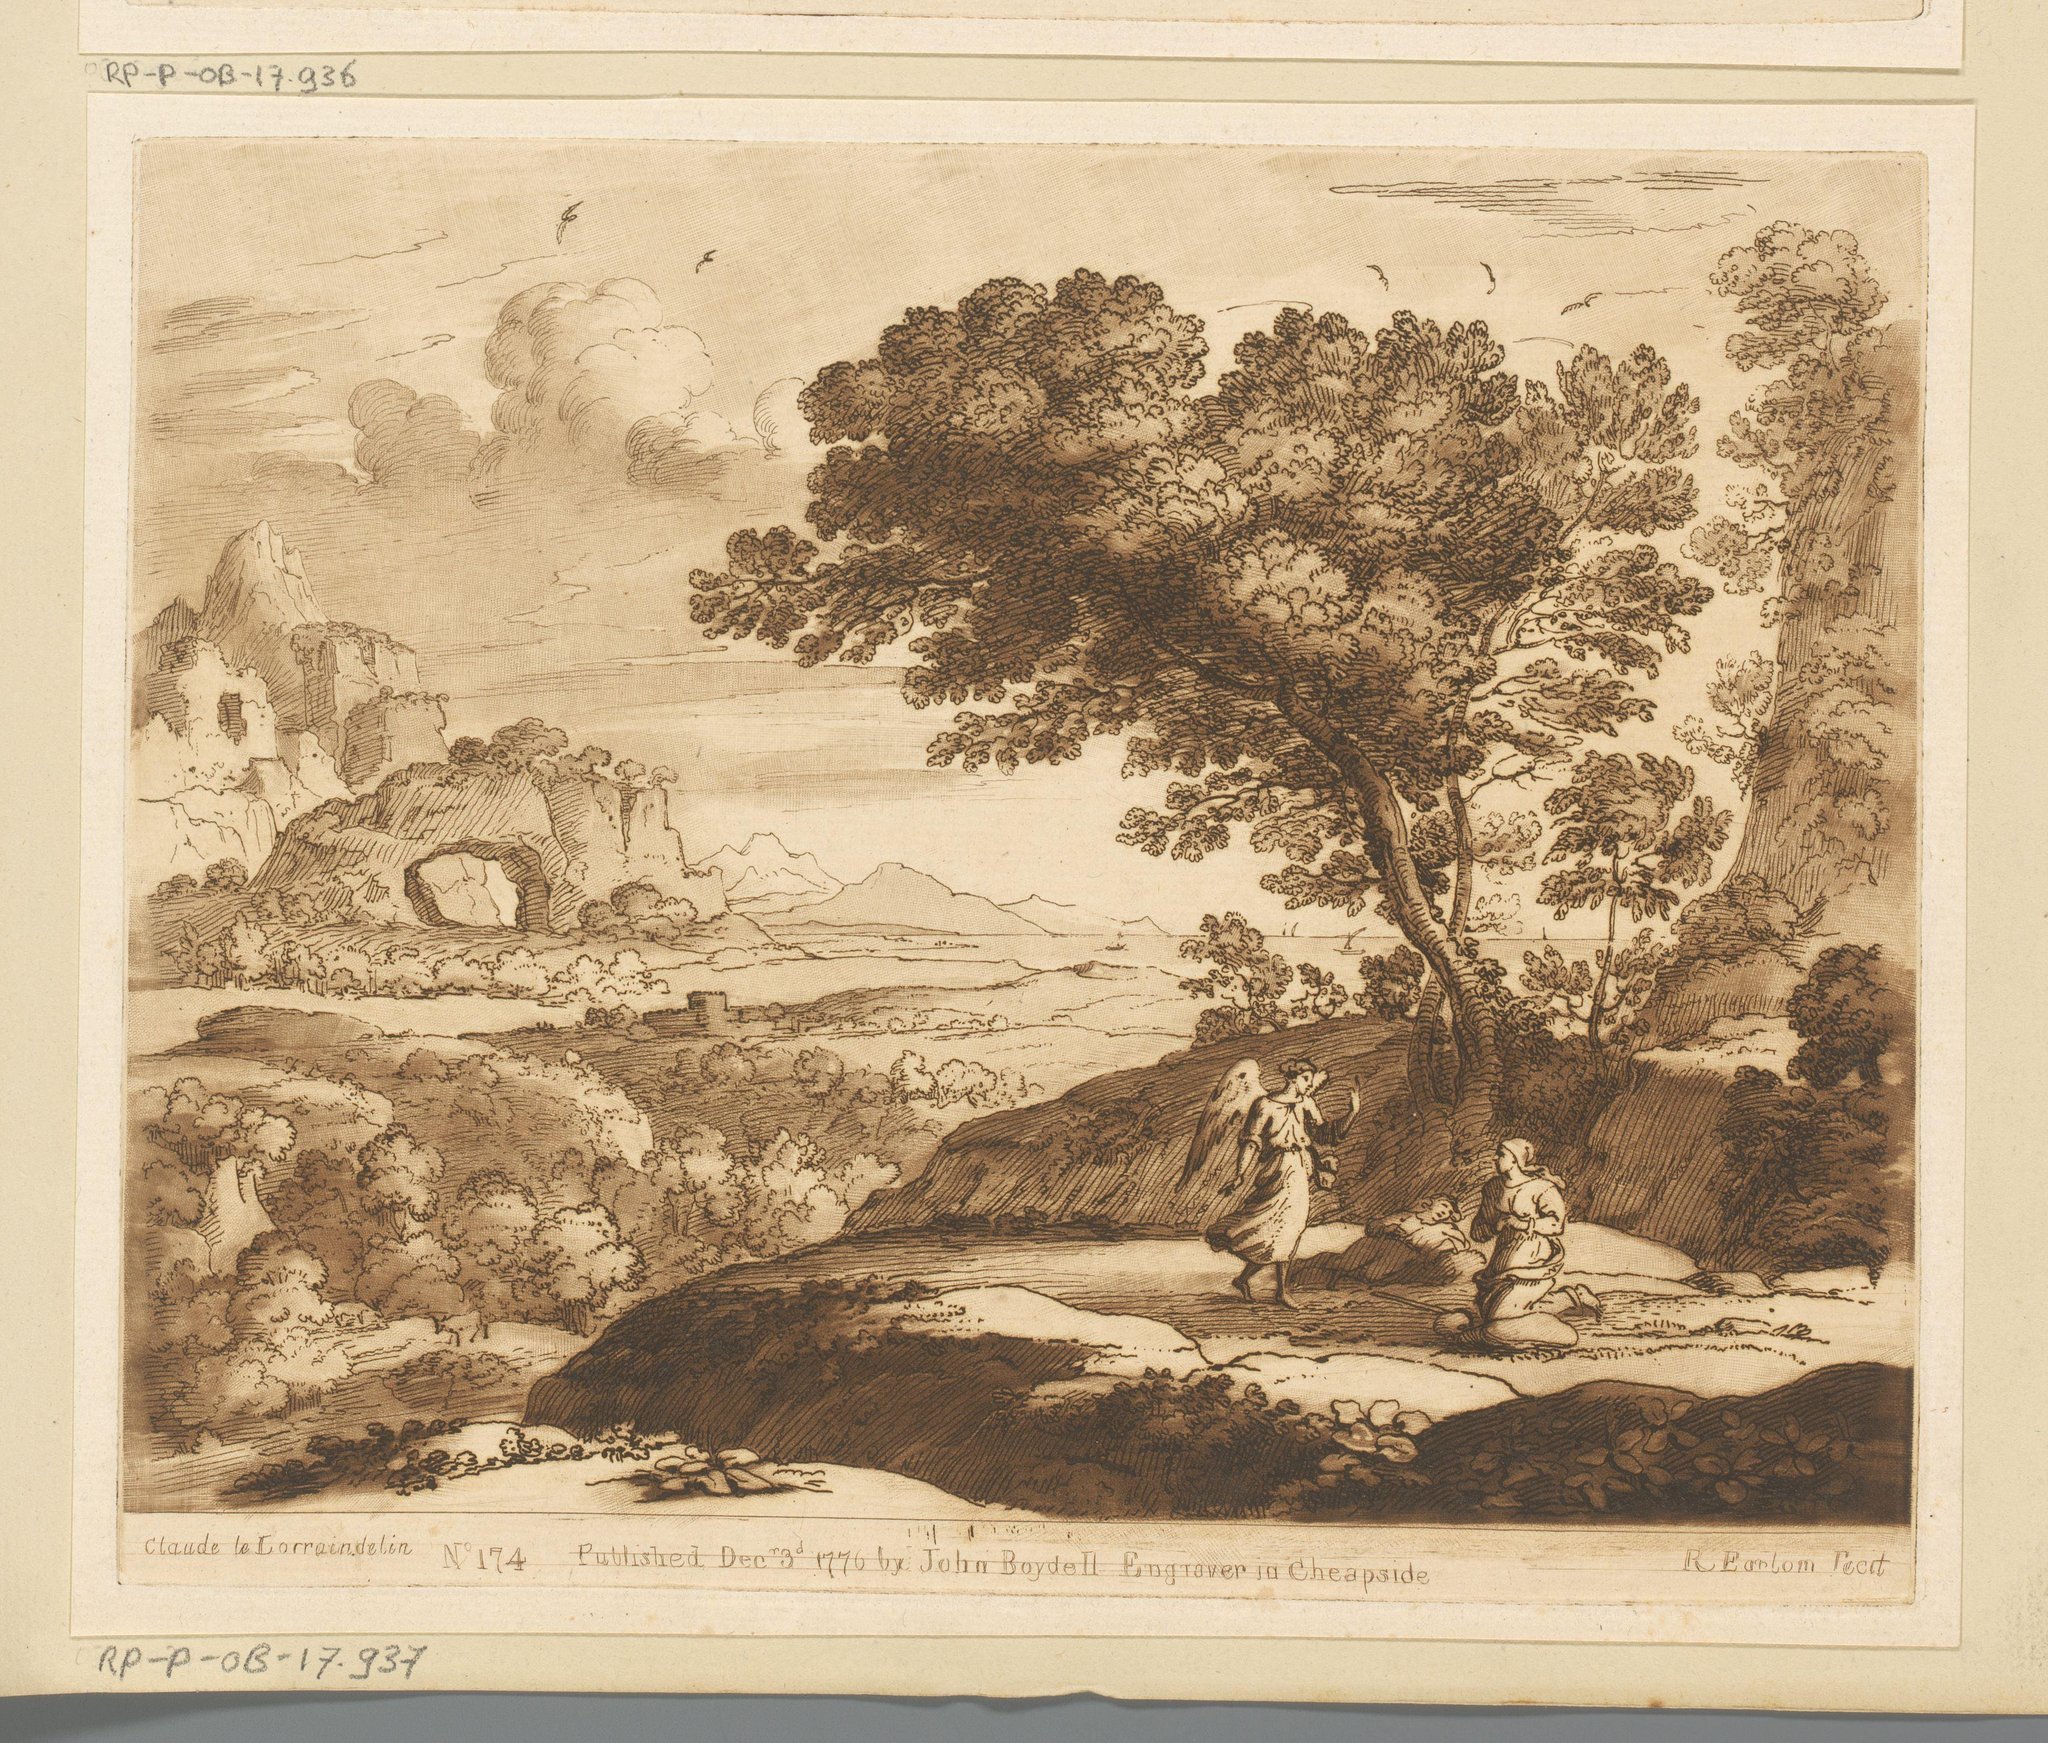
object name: print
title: Landschap met Hagar, Ismaël en de engel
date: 1776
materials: paper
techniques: etching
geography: london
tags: an angel appears and reveals a well of water to hagar, mountains - hh - ideal landscapes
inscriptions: date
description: Vanaf 1774 publiceerde John Boydell tweehonderd prenten naar het tekeningenboek Liber Veritatis van Claude Lorrain, in het bezit van de hertogen van Cavendish. Deze prenten werden vanaf 1777 in twee volumes gebundeld uitgegeven.